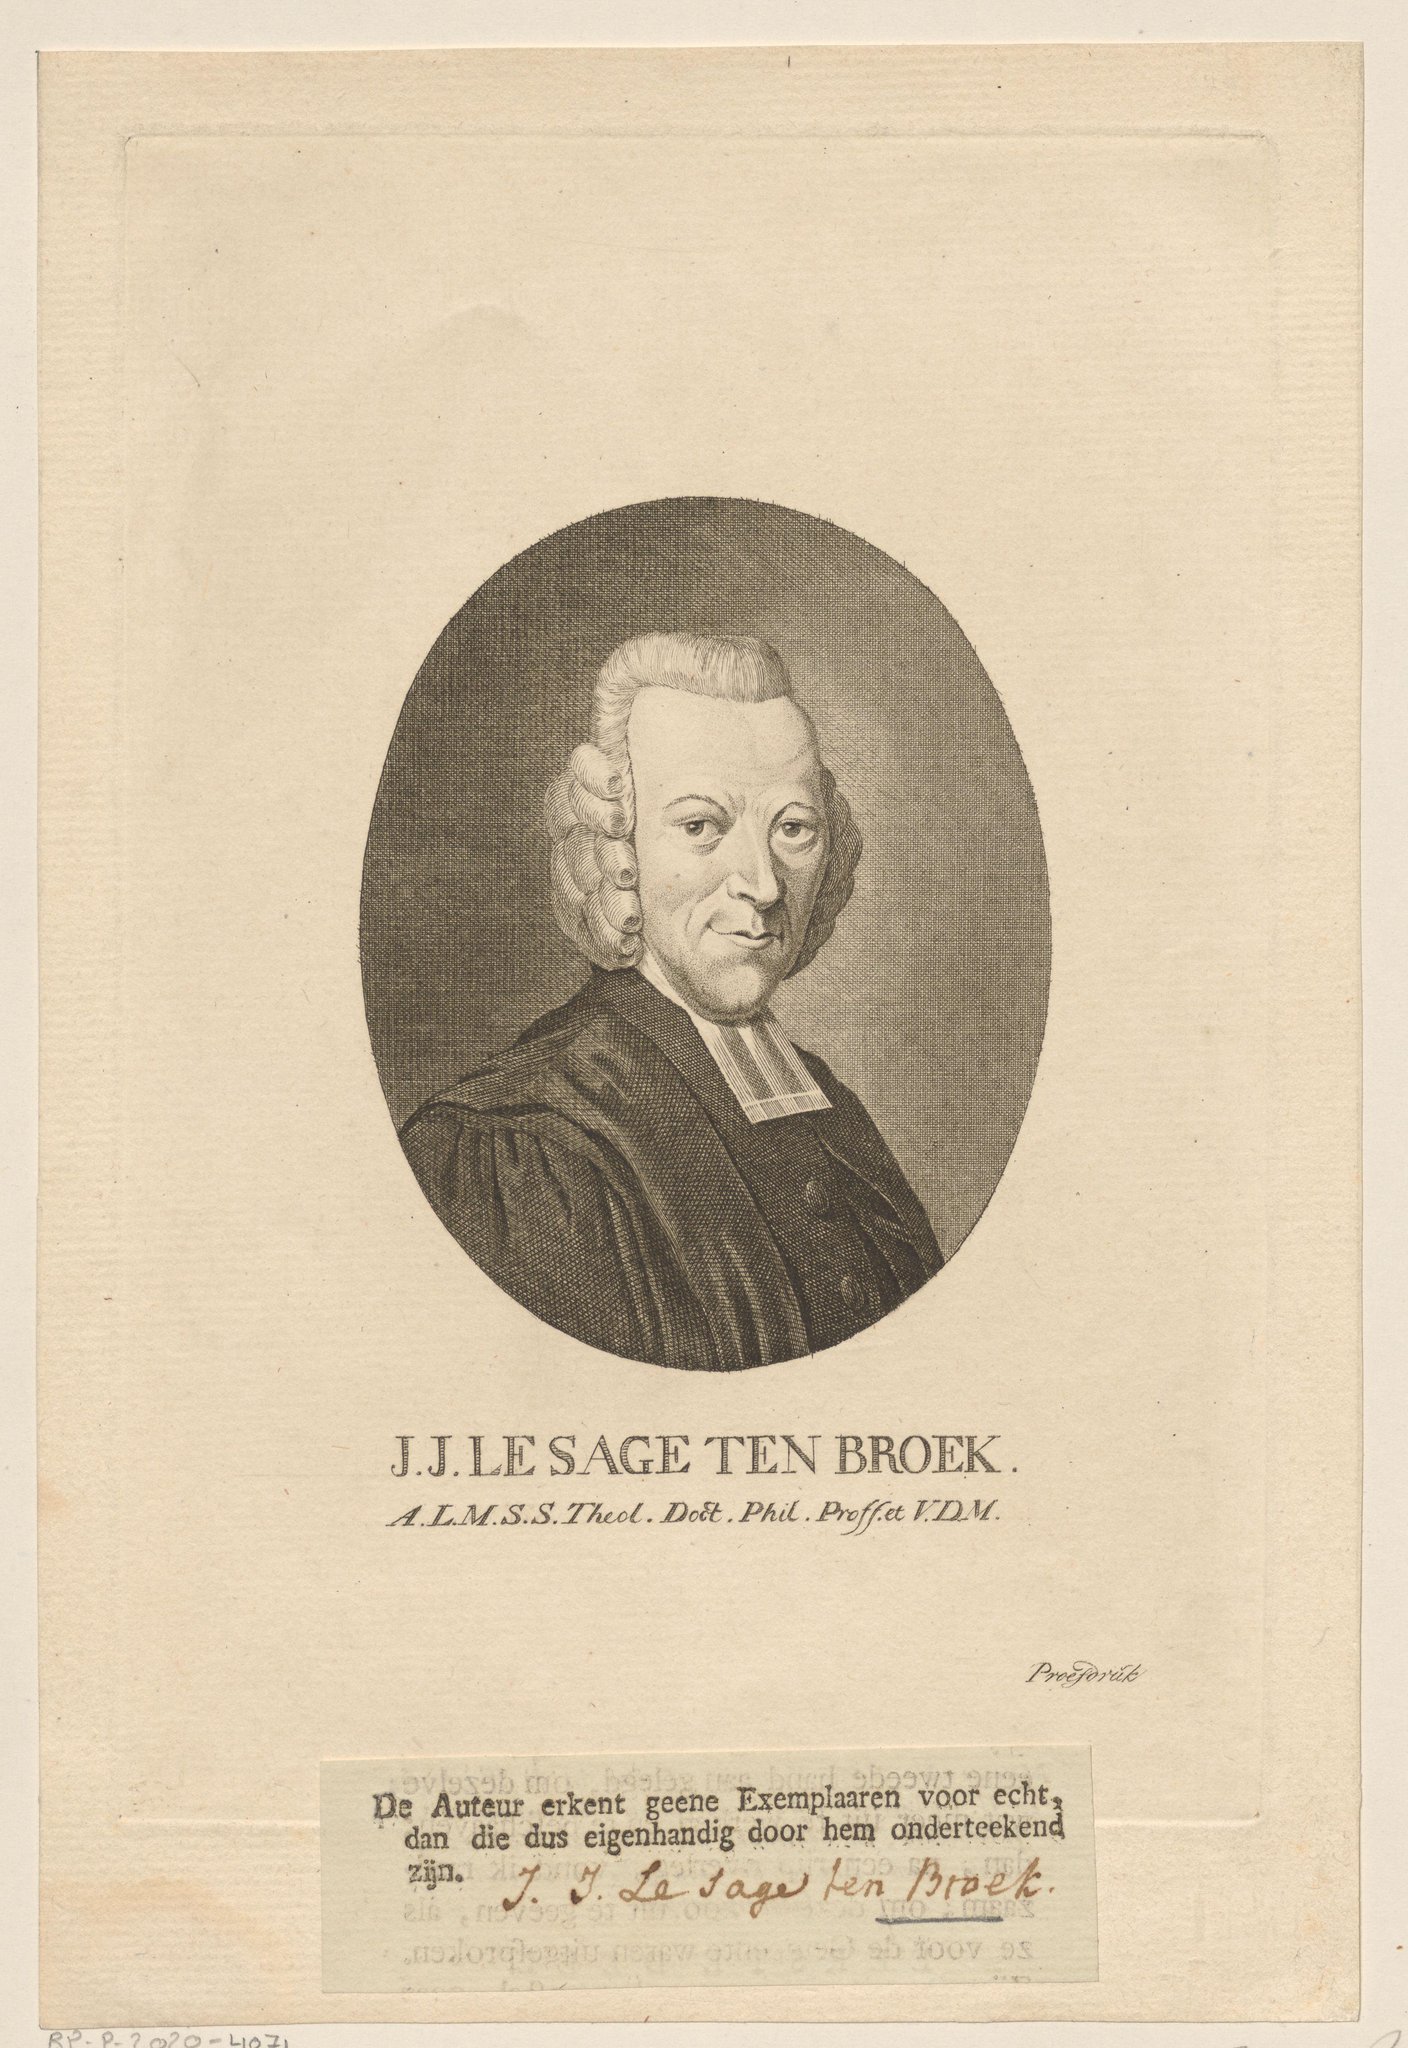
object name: print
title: Portret van Johan Jacob le Sage ten Broek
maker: Anonymous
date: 1775-1799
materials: paper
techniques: engraving, letterpress printing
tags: rotterdam, historical persons, professor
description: Op de prent is een strookje uit een boek geplakt met tekst in boekdruk en handgeschreven ondertekend 'J.J. le Sage ten Broek'.